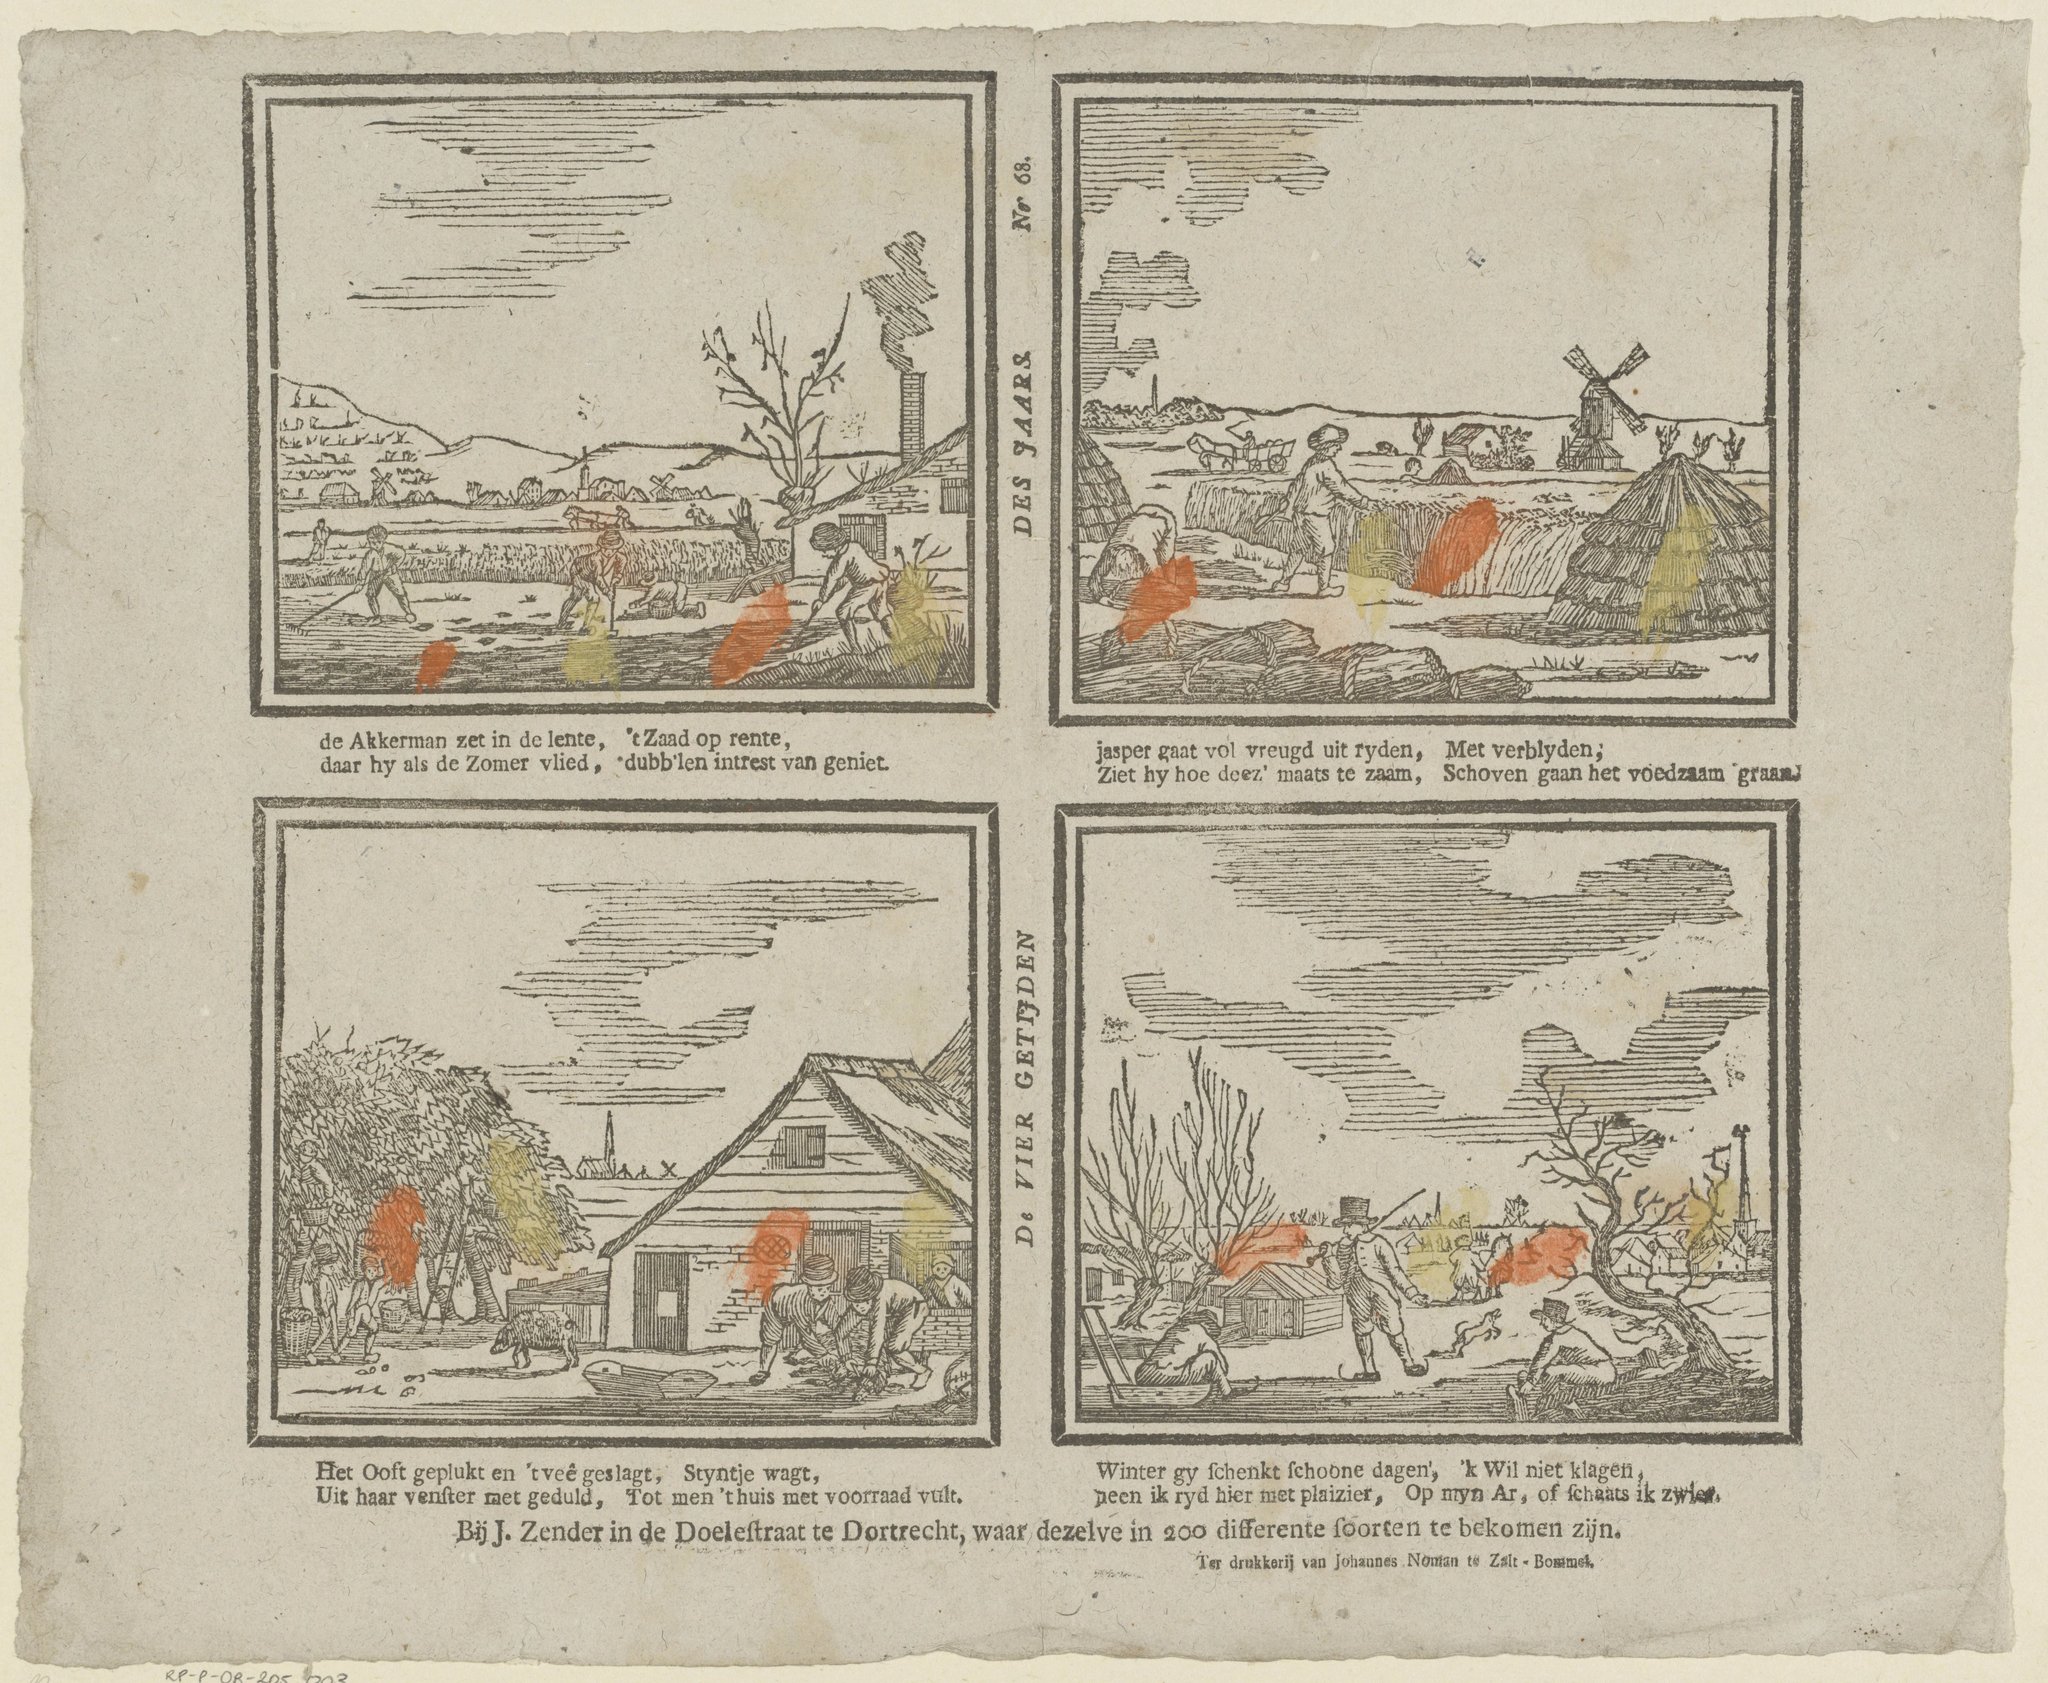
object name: print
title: De vier getijden des jaars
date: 1806-1830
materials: paper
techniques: colour, letterpress printing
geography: sneek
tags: the four seasons of the year ~ human activities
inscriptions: collector's mark: Lugt 2760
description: Blad met 4 voorstellingen van de vier jaargetijden en bijbehorende activiteiten. Onder elke afbeelding een tweeregelig vers. Genummerd midden boven: No. 68.